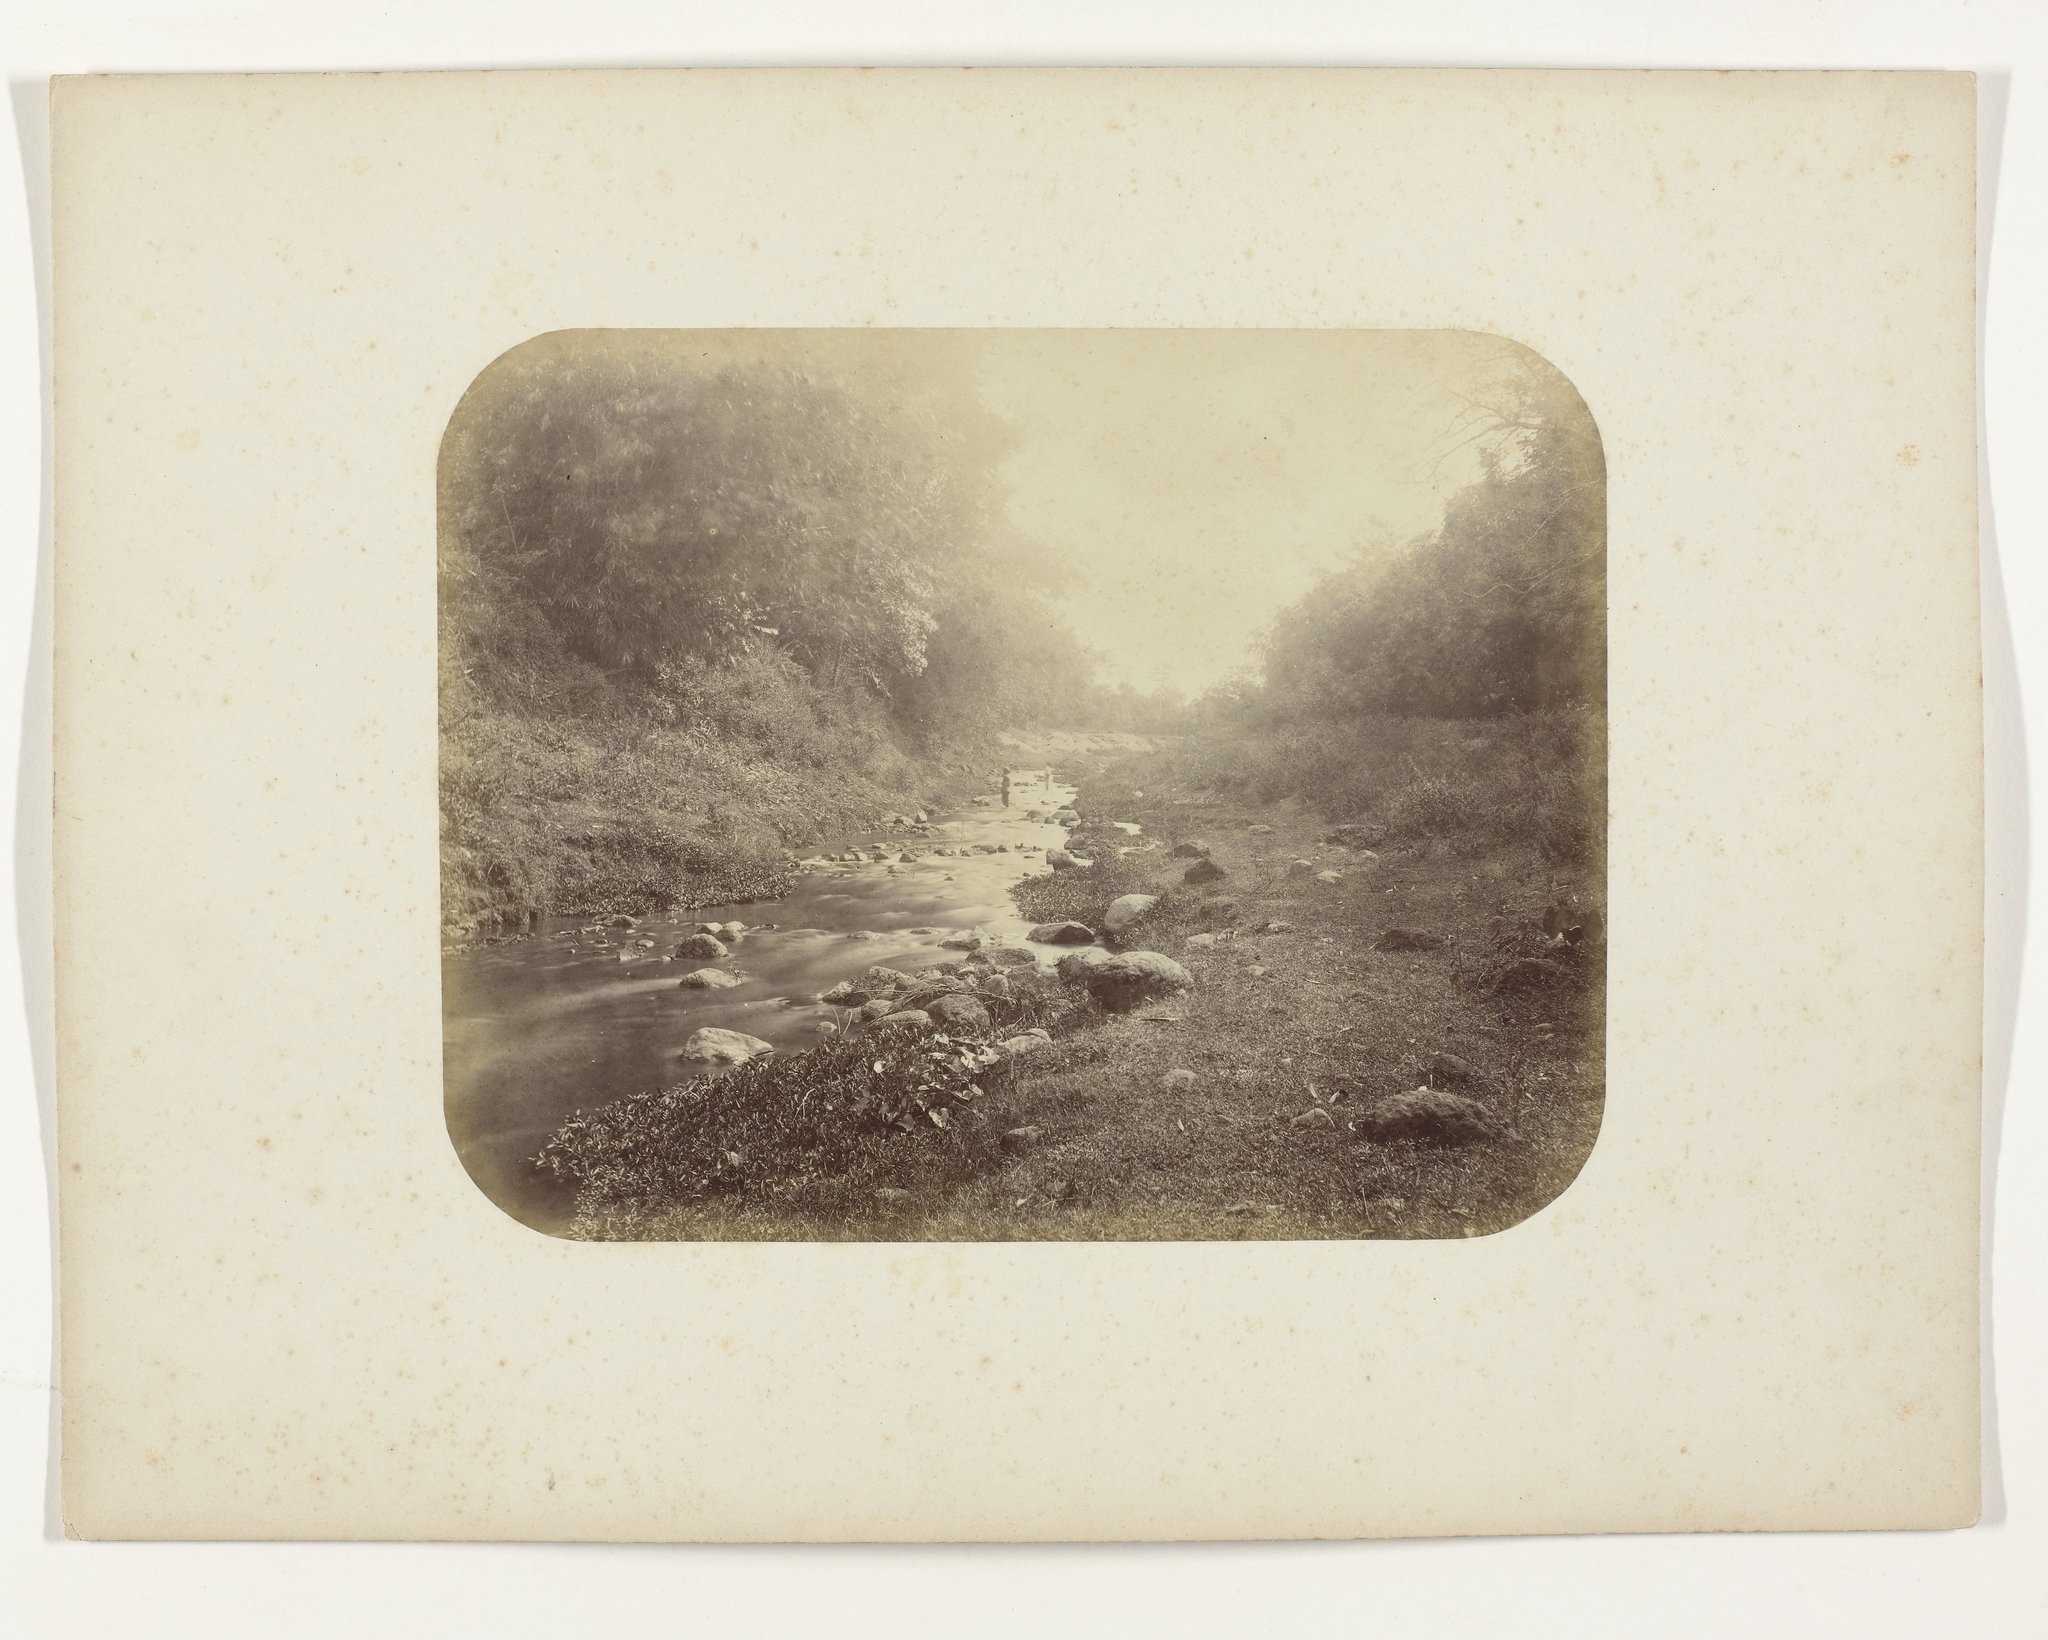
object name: photograph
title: Ondiepe rivier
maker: herman salzwedel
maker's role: fotograaf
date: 1876-1884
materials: photographic support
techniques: albumen print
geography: surabaya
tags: utrecht, the hague, colonial system, river, java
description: Een ondiep rivier met keien in het water en op de kant. In de rivier staan twee inlanders op enige afstand van elkaar. Onderdeel van het fotoalbum door de Soerabayasche Vereeniging van Suikerfabrikanten aangeboden aan Frederik Beyerinck, resident van Soerabaja.